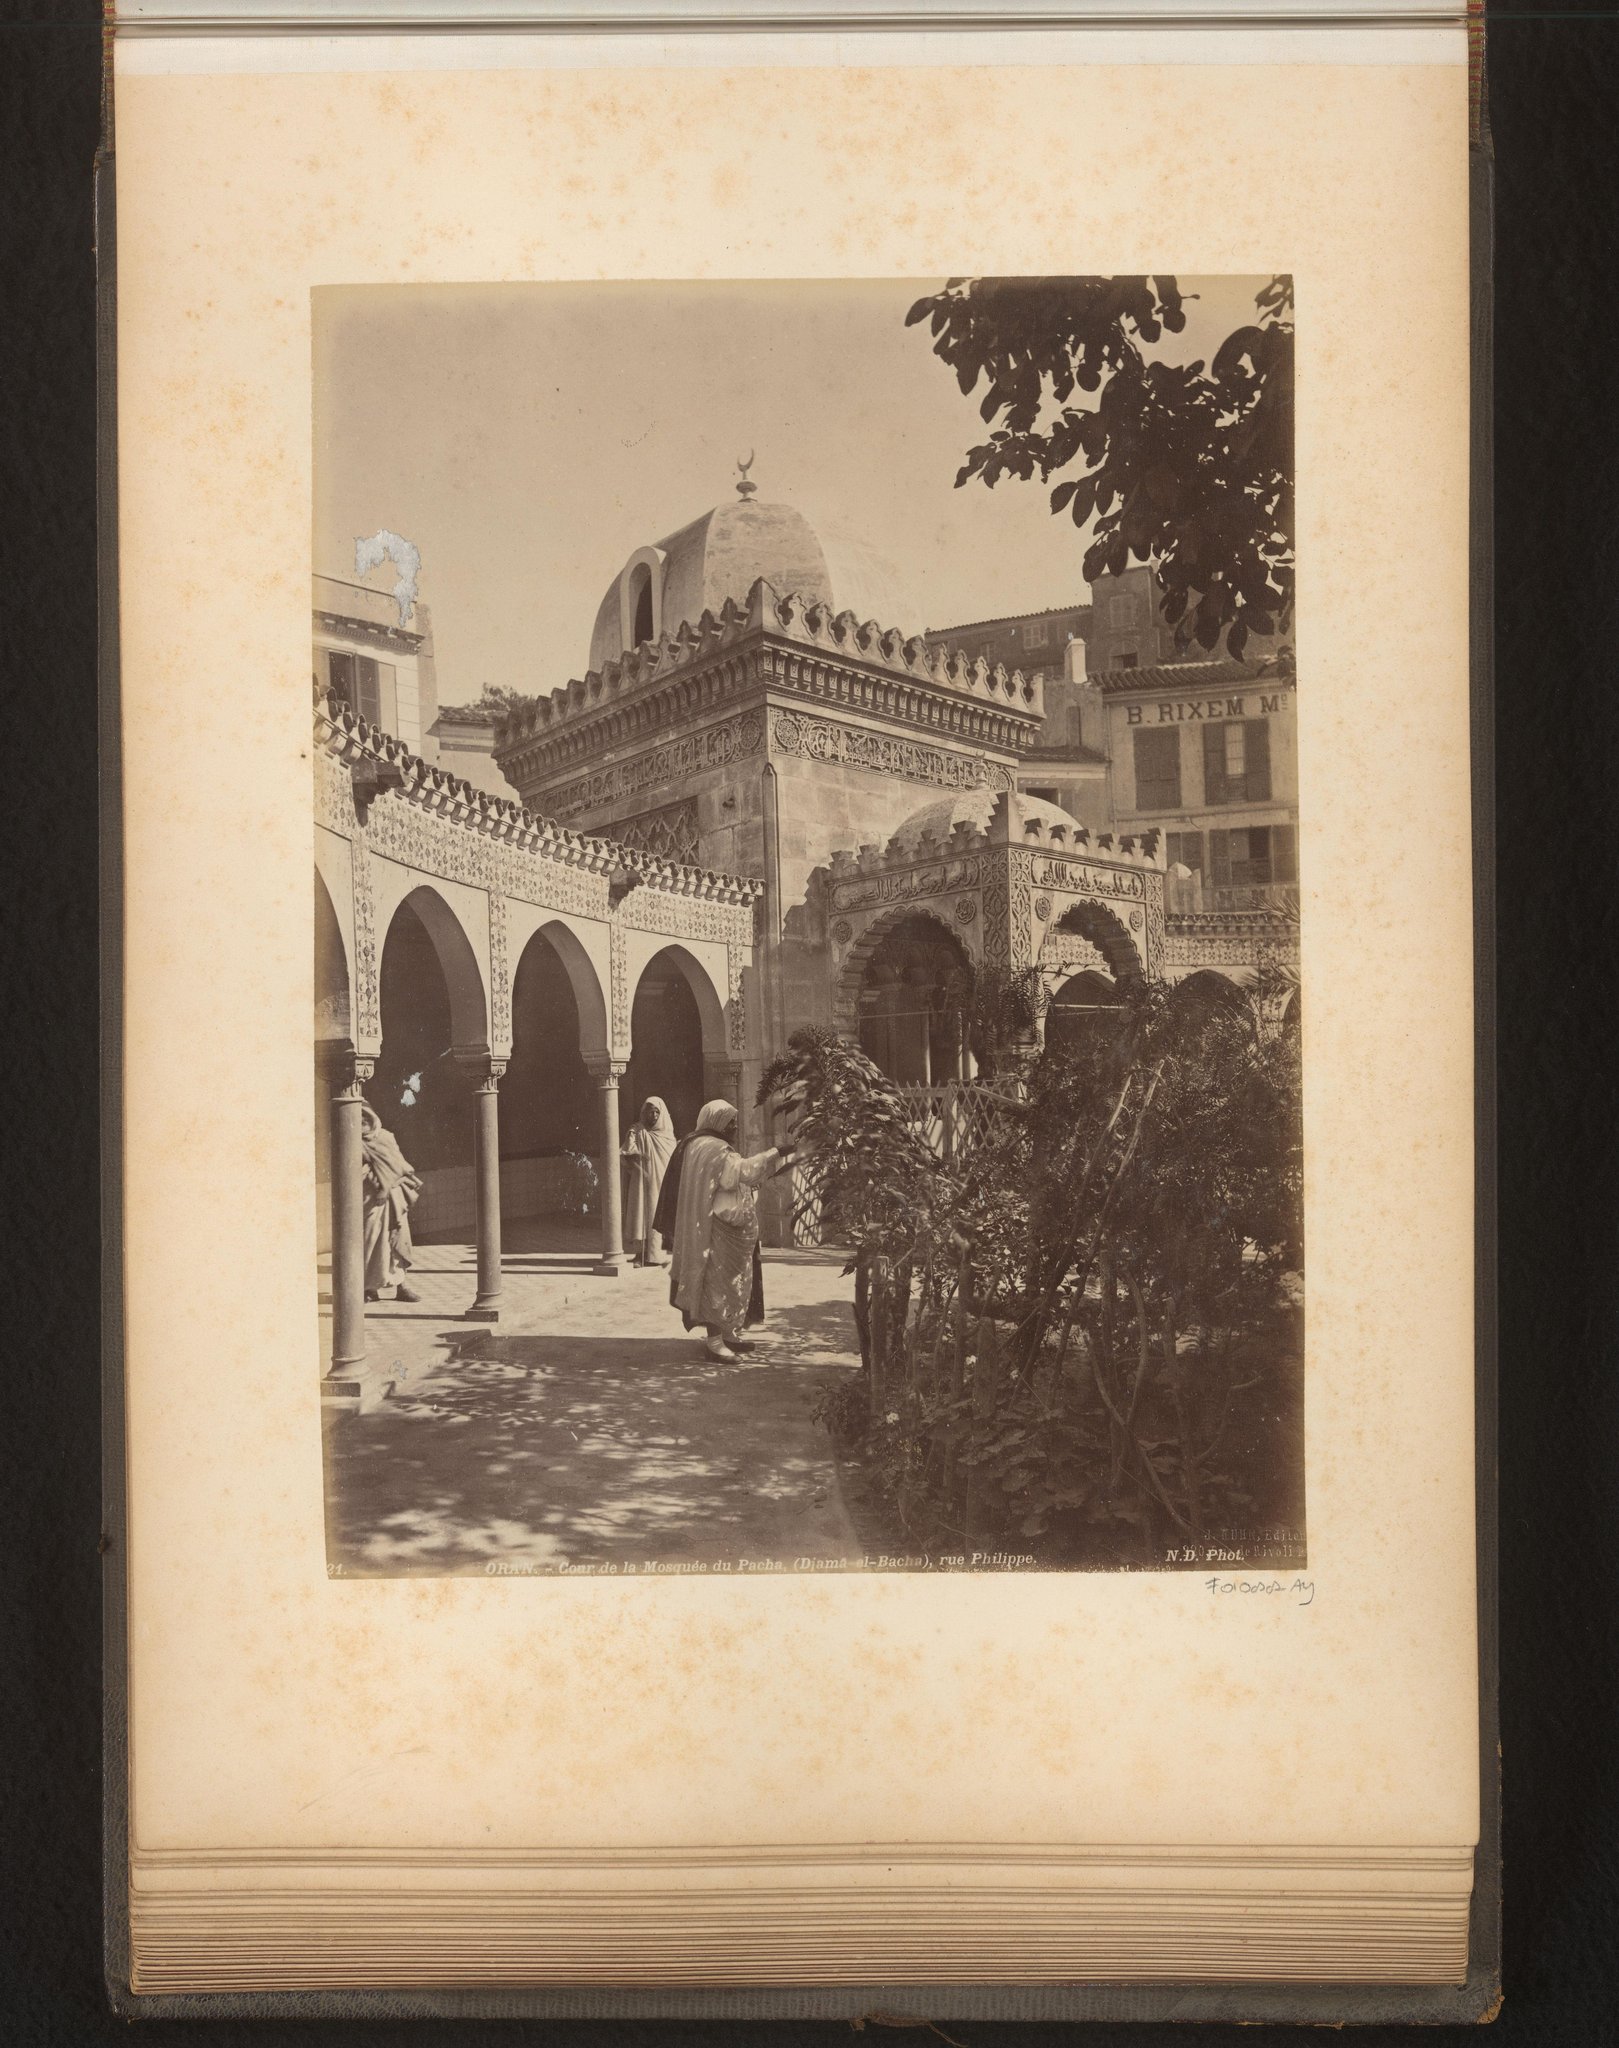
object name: photograph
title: Hassan Pasha Moskee te Oran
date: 1880-1900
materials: photographic support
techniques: albumen print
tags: trees, historical persons, temple, shrine ~ islam, mohammedanism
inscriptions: check stamp: ‘J. Kuhn Editeur/ 220 Rue de Rivoli Paris’, number: ‘21’